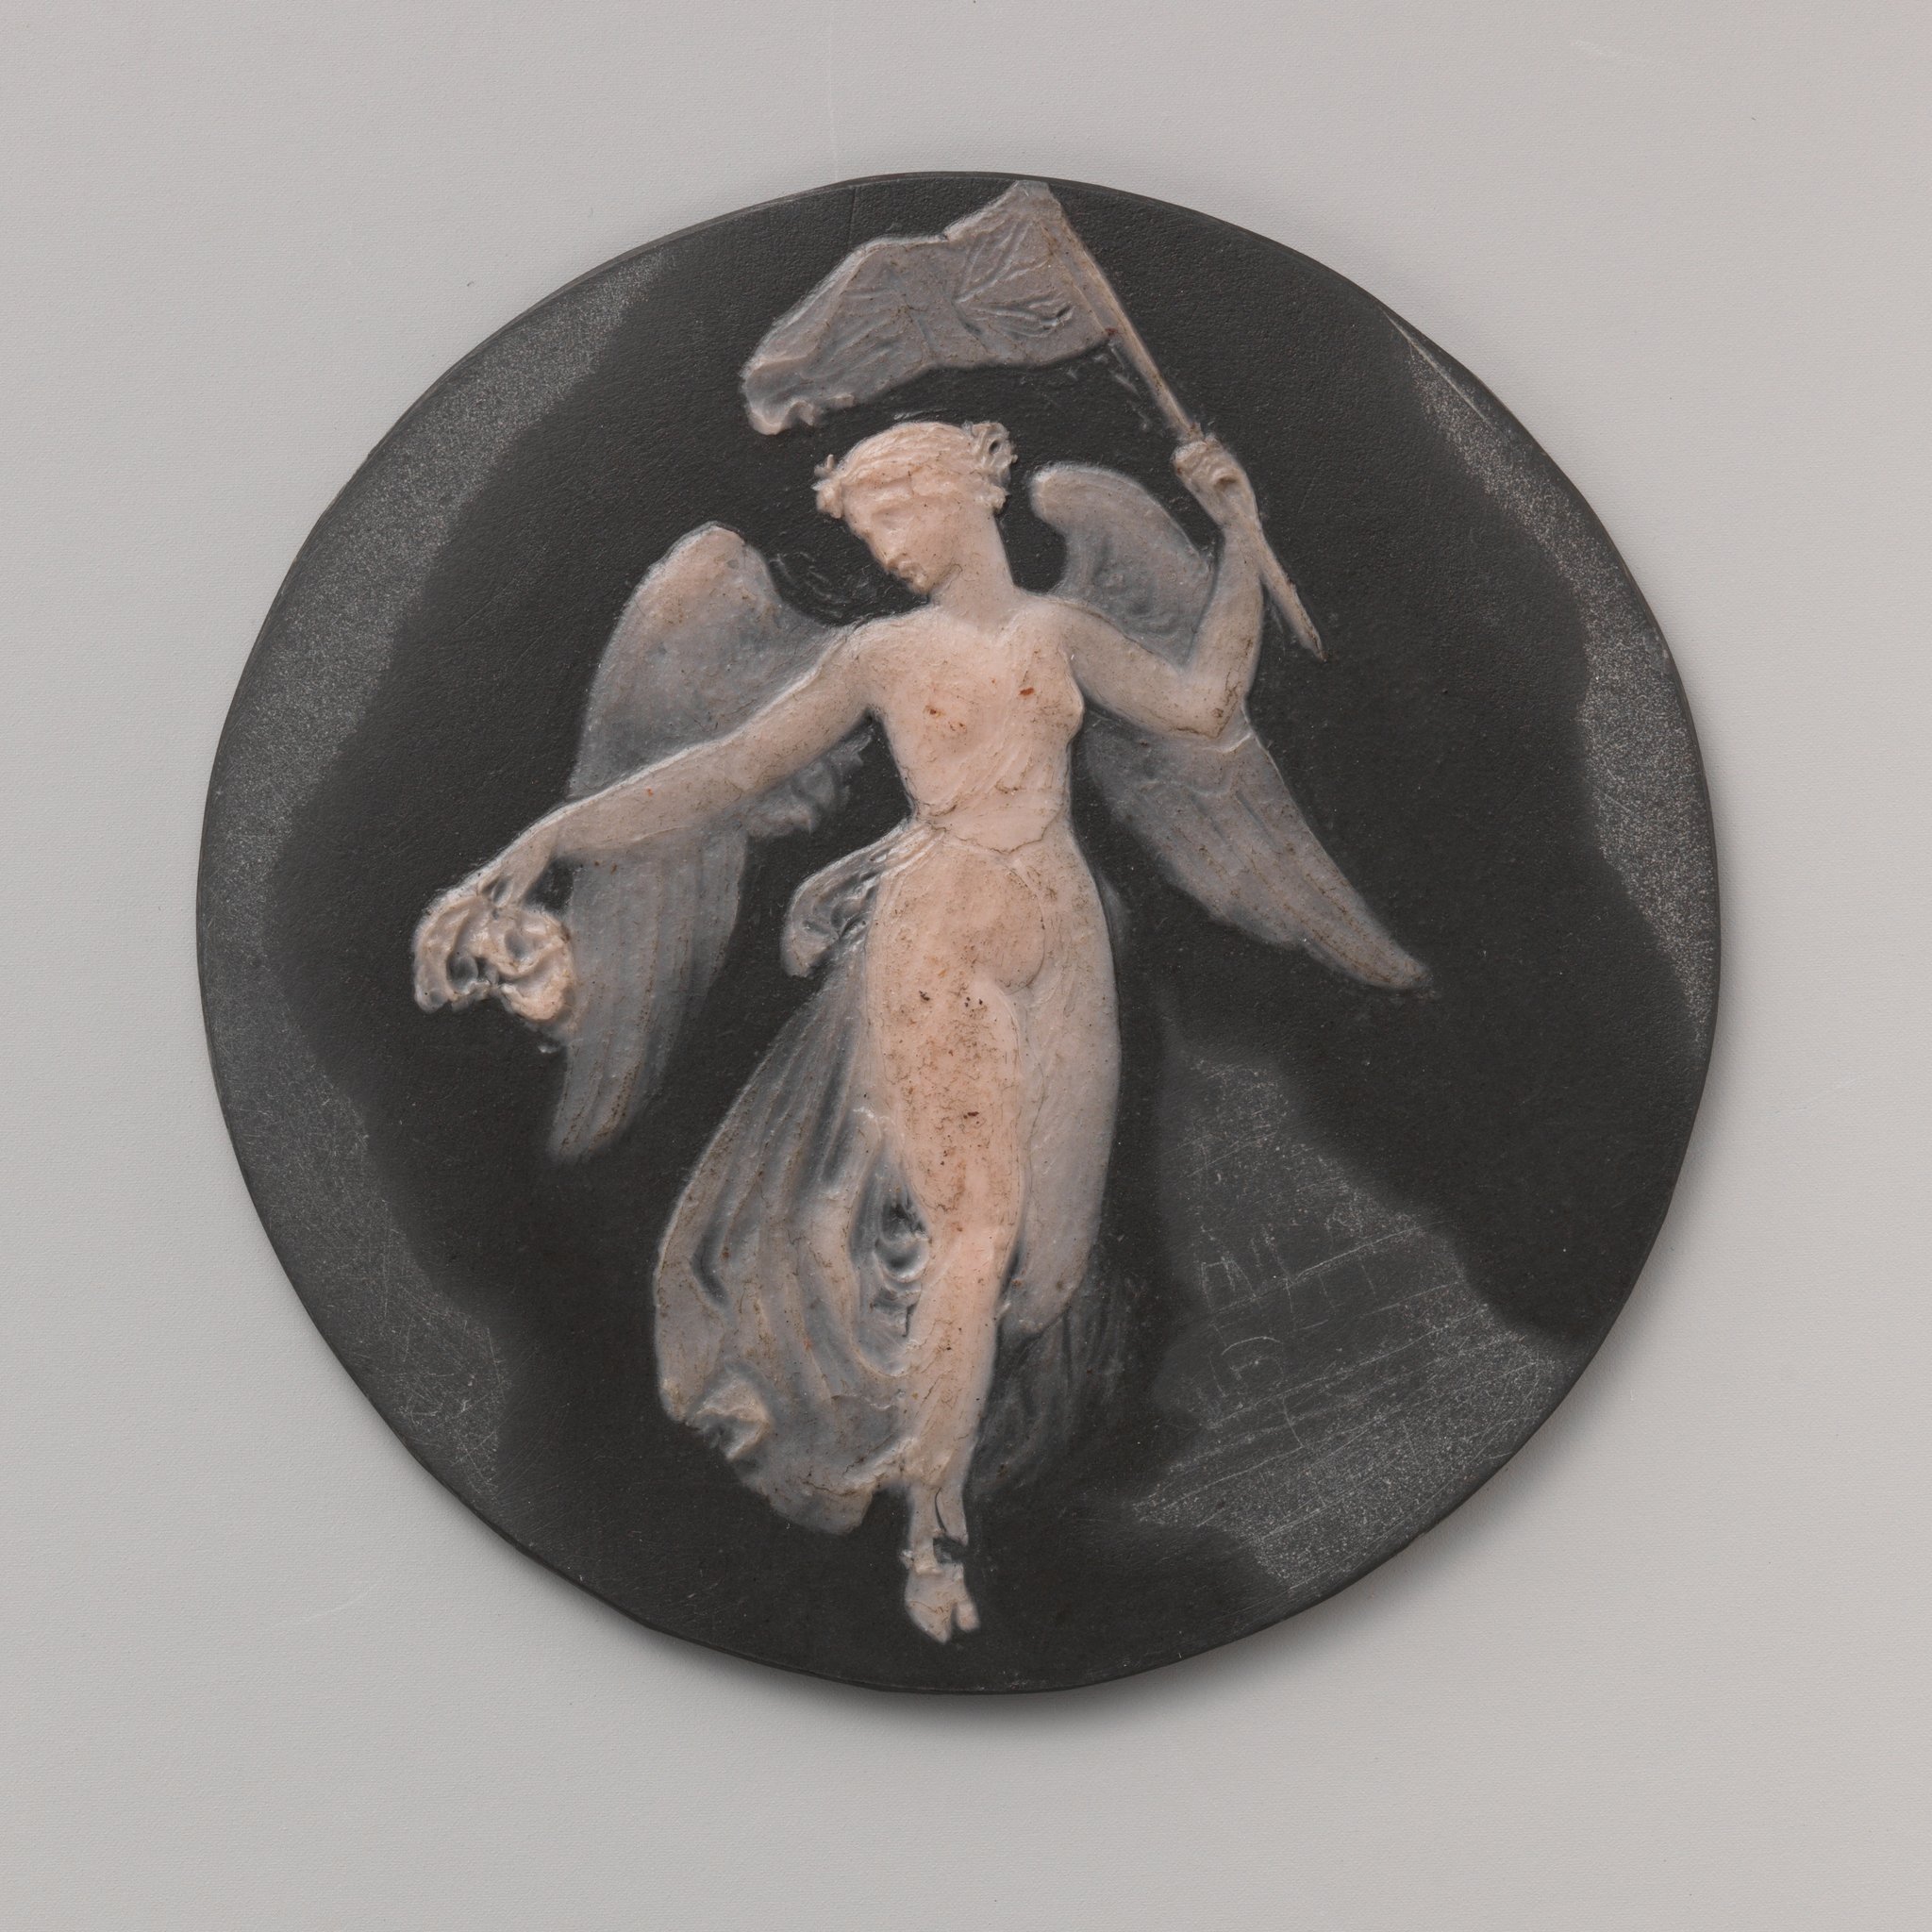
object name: wax study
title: Study for "Flying Victory"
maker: william wyon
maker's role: artist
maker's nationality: british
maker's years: 1795-1851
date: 1830-1840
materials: wax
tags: victory,flags